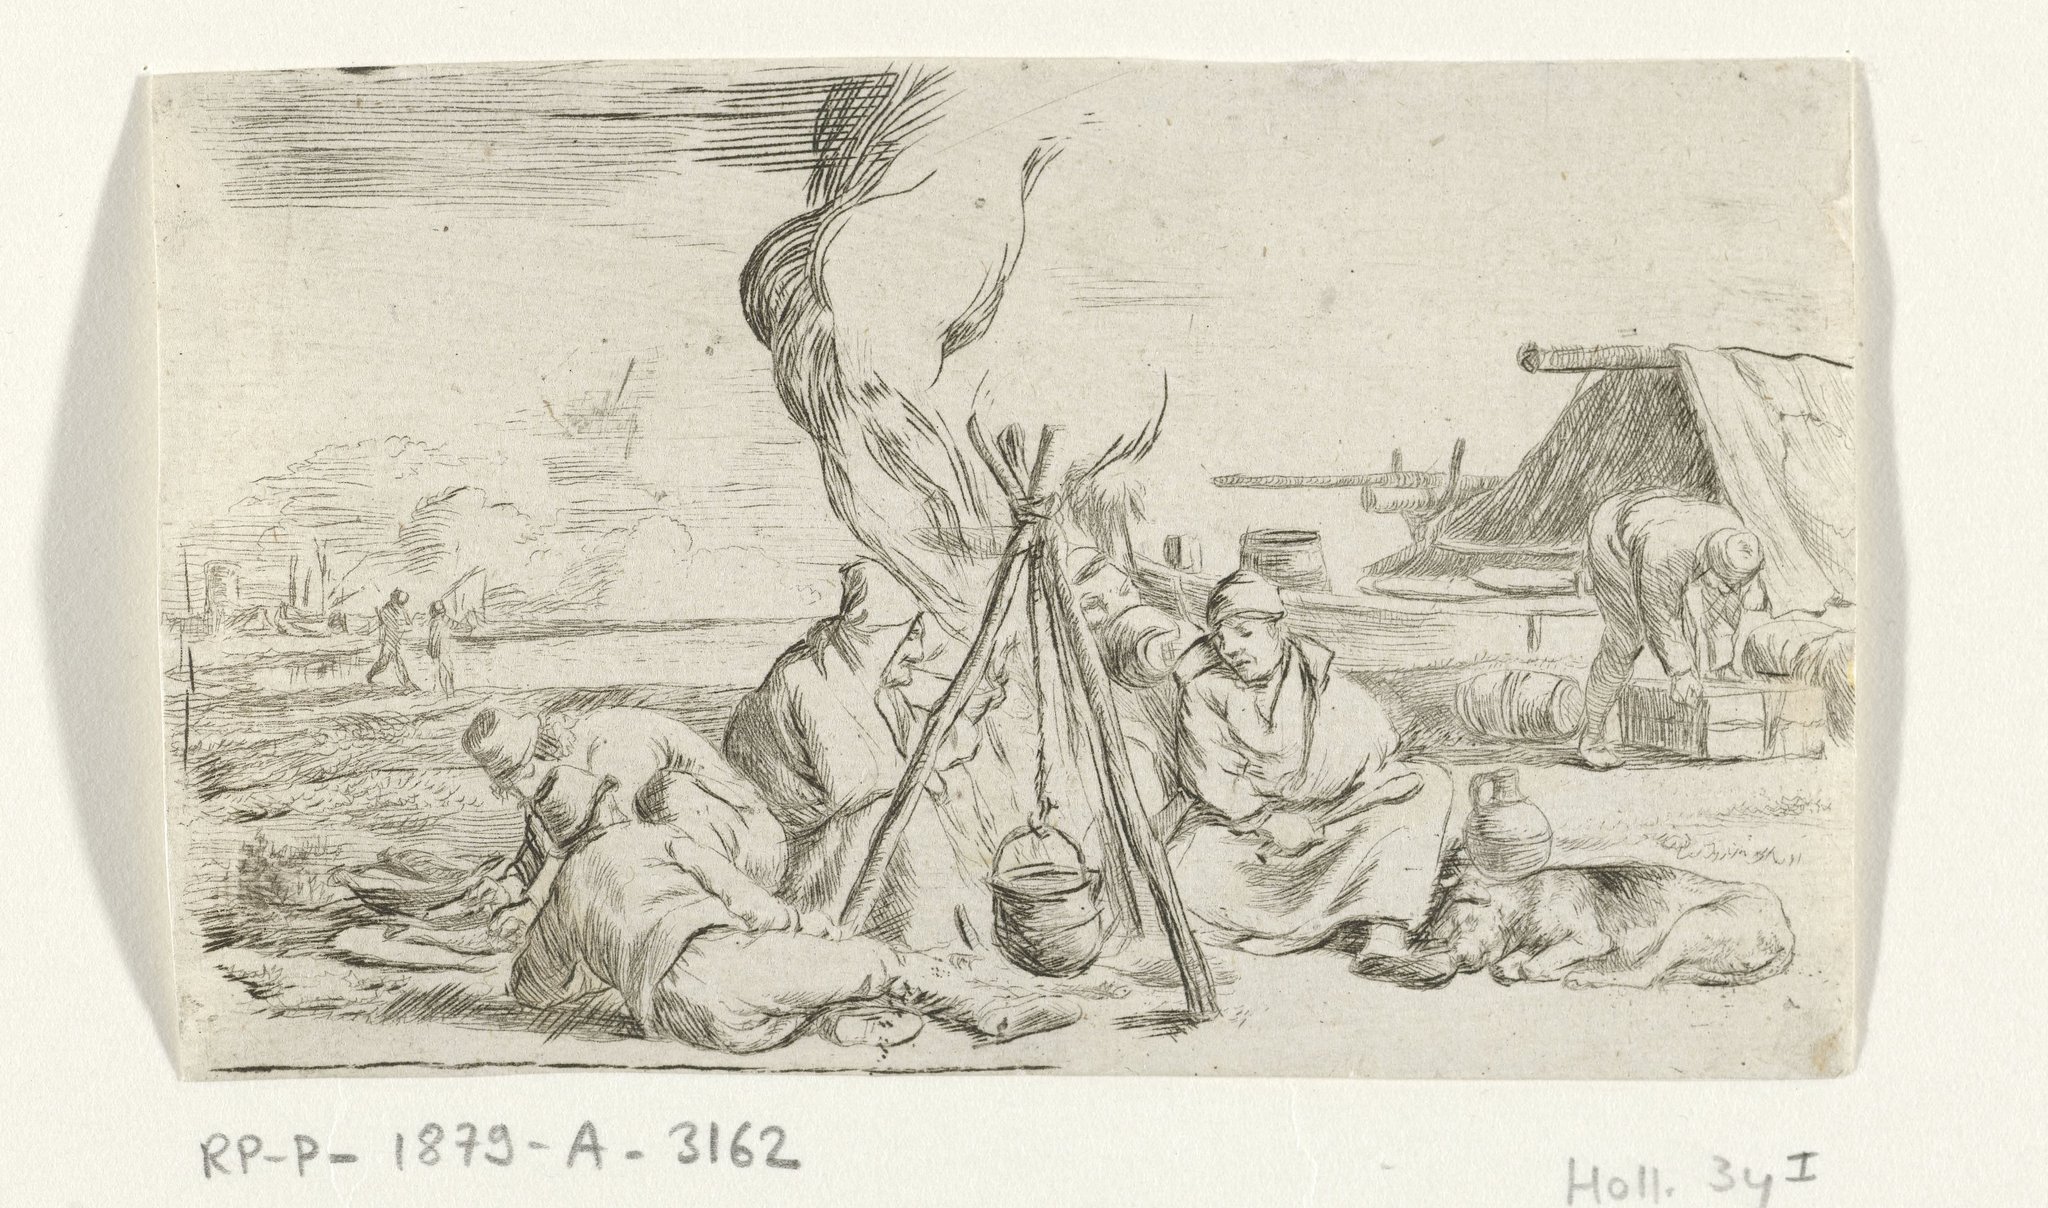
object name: print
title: Vijf soldaten rond een kampvuur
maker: jan van ossenbeeck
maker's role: print maker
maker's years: 1623-1674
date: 1647-1674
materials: paper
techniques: engraving, etching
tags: camp-fire; watch-fire, recreation ~ the soldier off duty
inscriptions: collector's mark: Lugt 2610, collector's mark: Lugt 2228